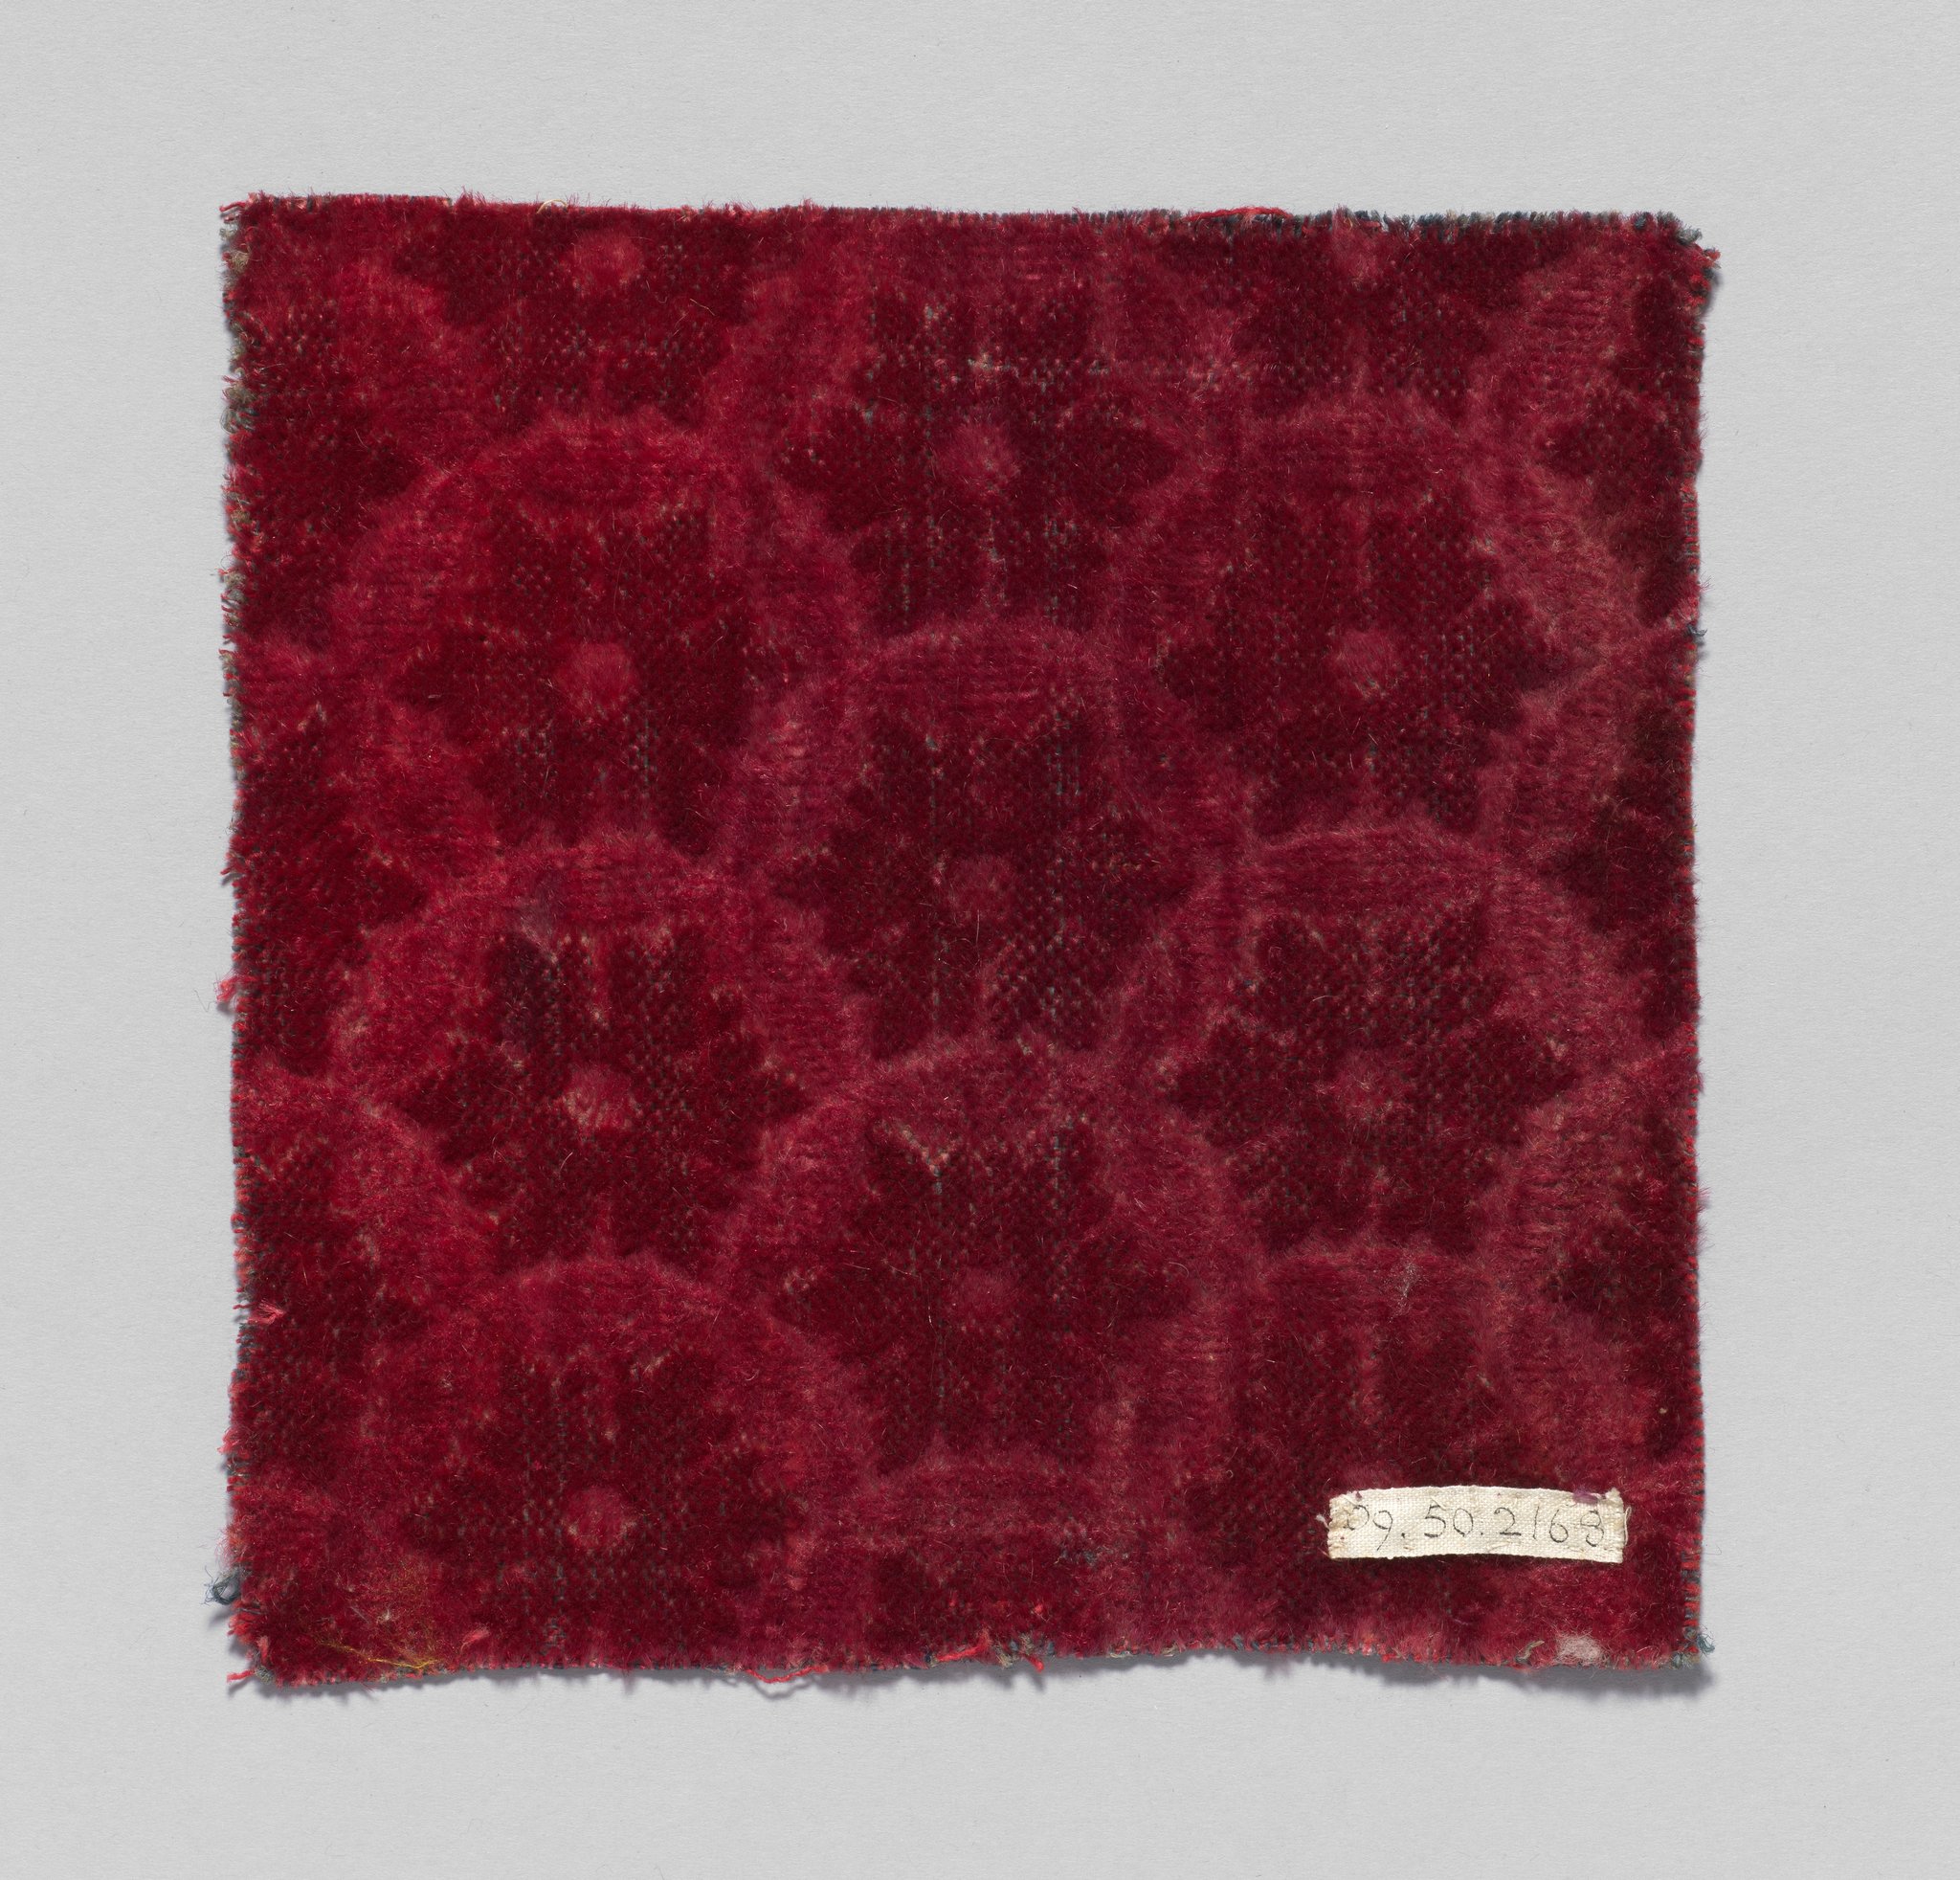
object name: piece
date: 1601-1700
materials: wool